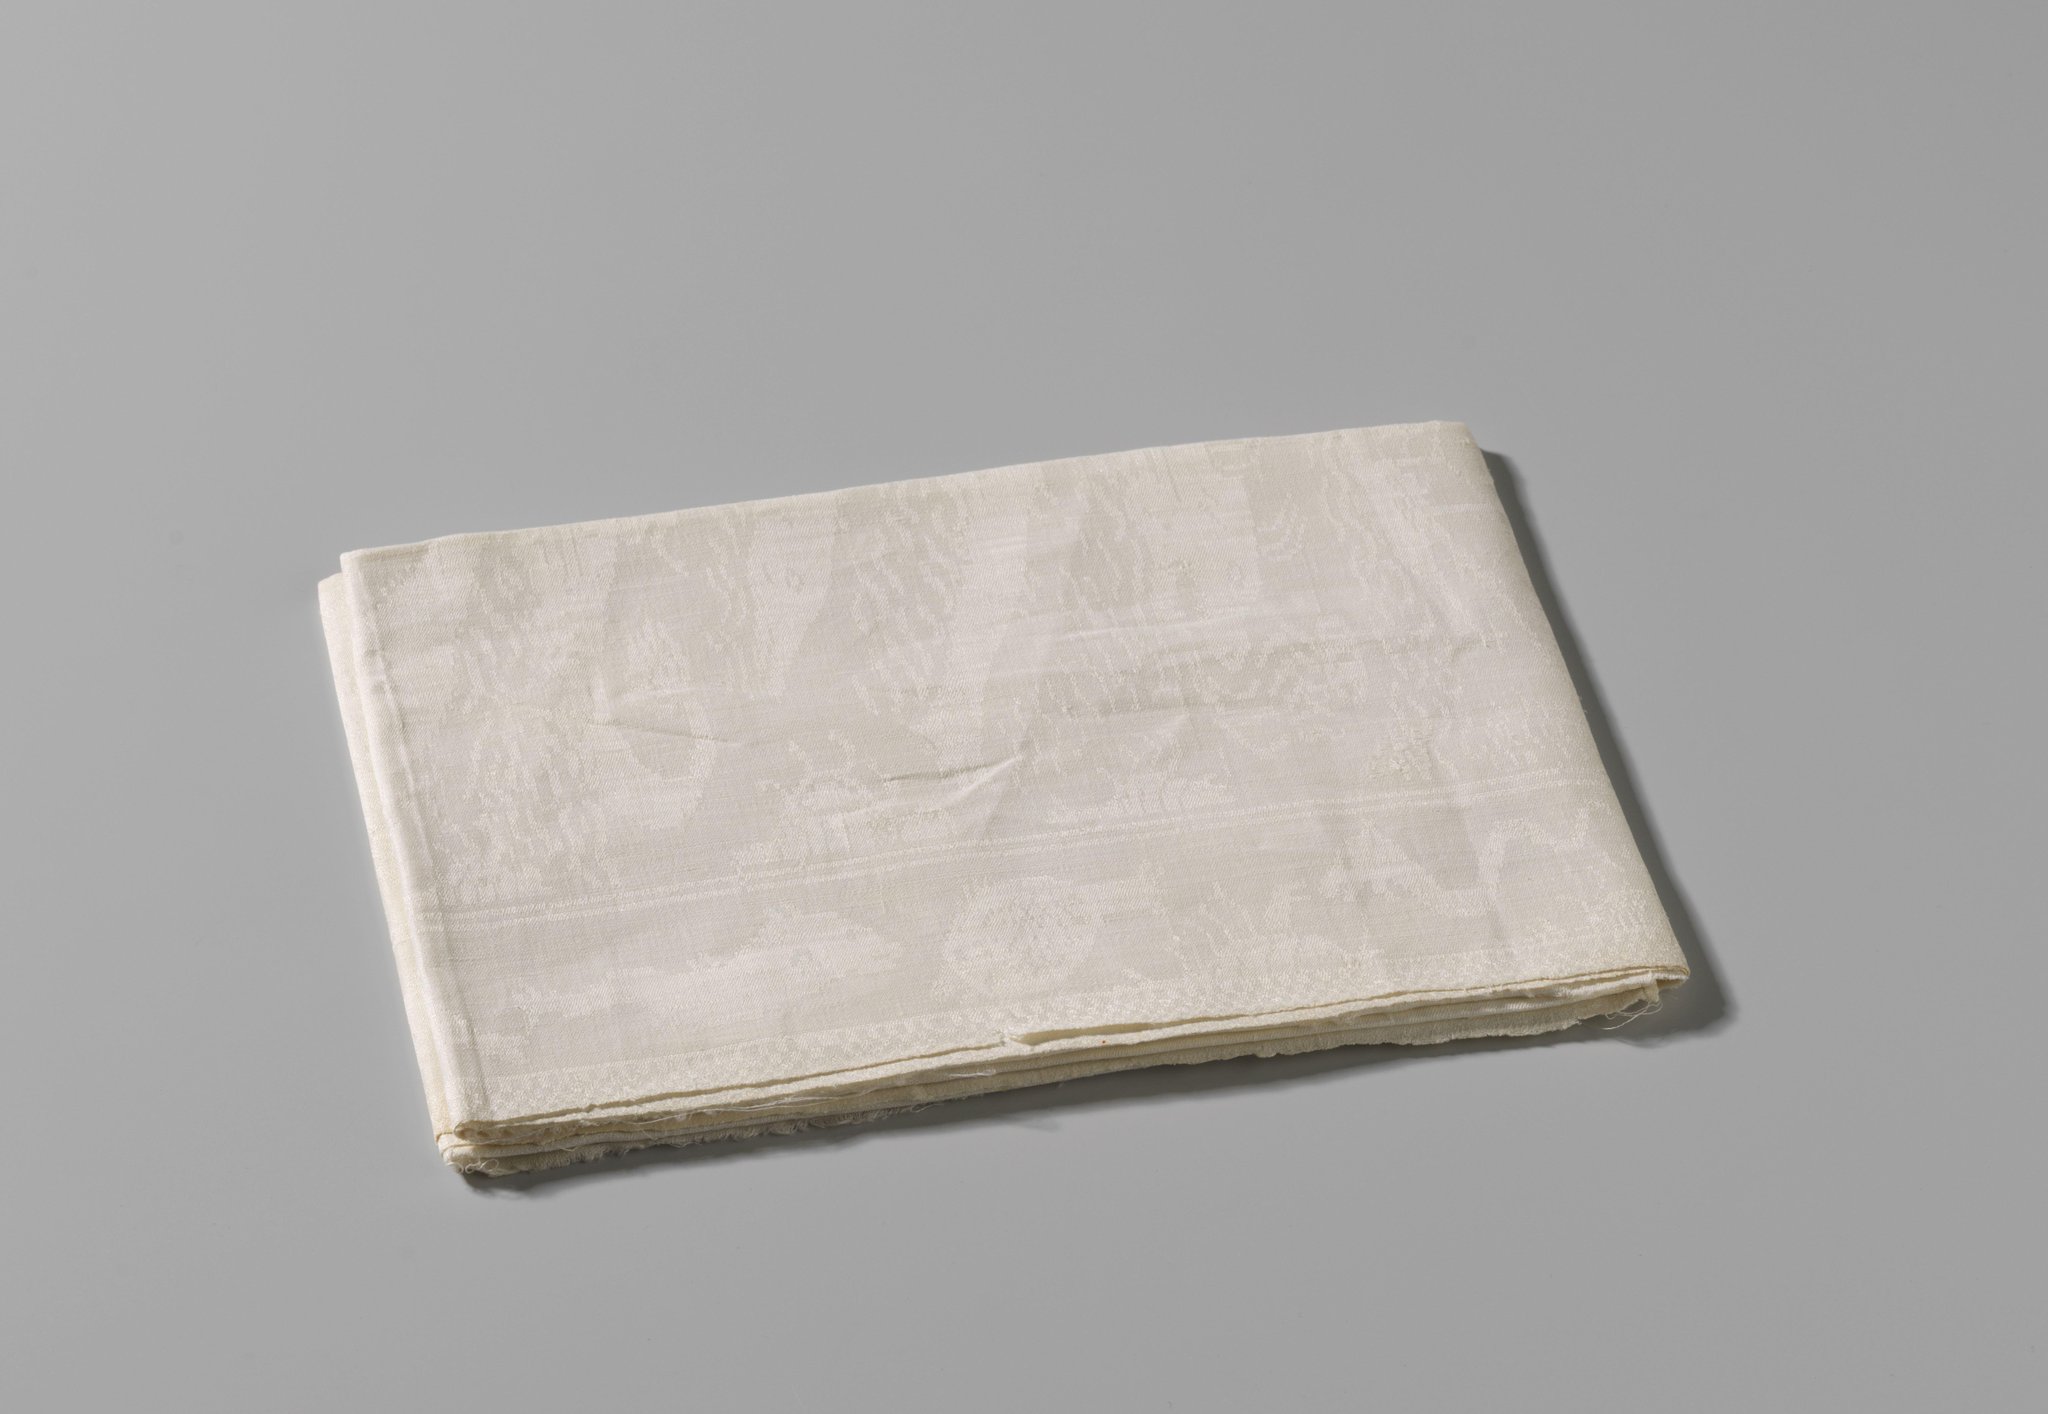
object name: napkin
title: Servet met schepen, vissen en de wapens van Scipio Meckama van Aijlva en Lucia van Eysinga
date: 1661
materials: linen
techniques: damask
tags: lucia van eysinga, scipio meckama van aijlva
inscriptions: mark: ‘L.V.A. 1661’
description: Servet van linnendamast met schepen, vissen en de wapens van Scipio Meckama van Aijlva en Lucia van Eysinga. Middenveld: het symmetrisch patroon vertoont: twee schepen, dolfijnen, zeemeerminnen, zeepaarden en diverse vissen. Staande randen: vis- en schaaldieren. In de brede liggende randen: een tak met bloemen, waaronder twee wapens met de onderschriften SCIPIO MECKAMA VAN ALVA en LUCIA VAN EYSINGA ANO 1661. In de hoeken geborduurd L.V.A. 1661.